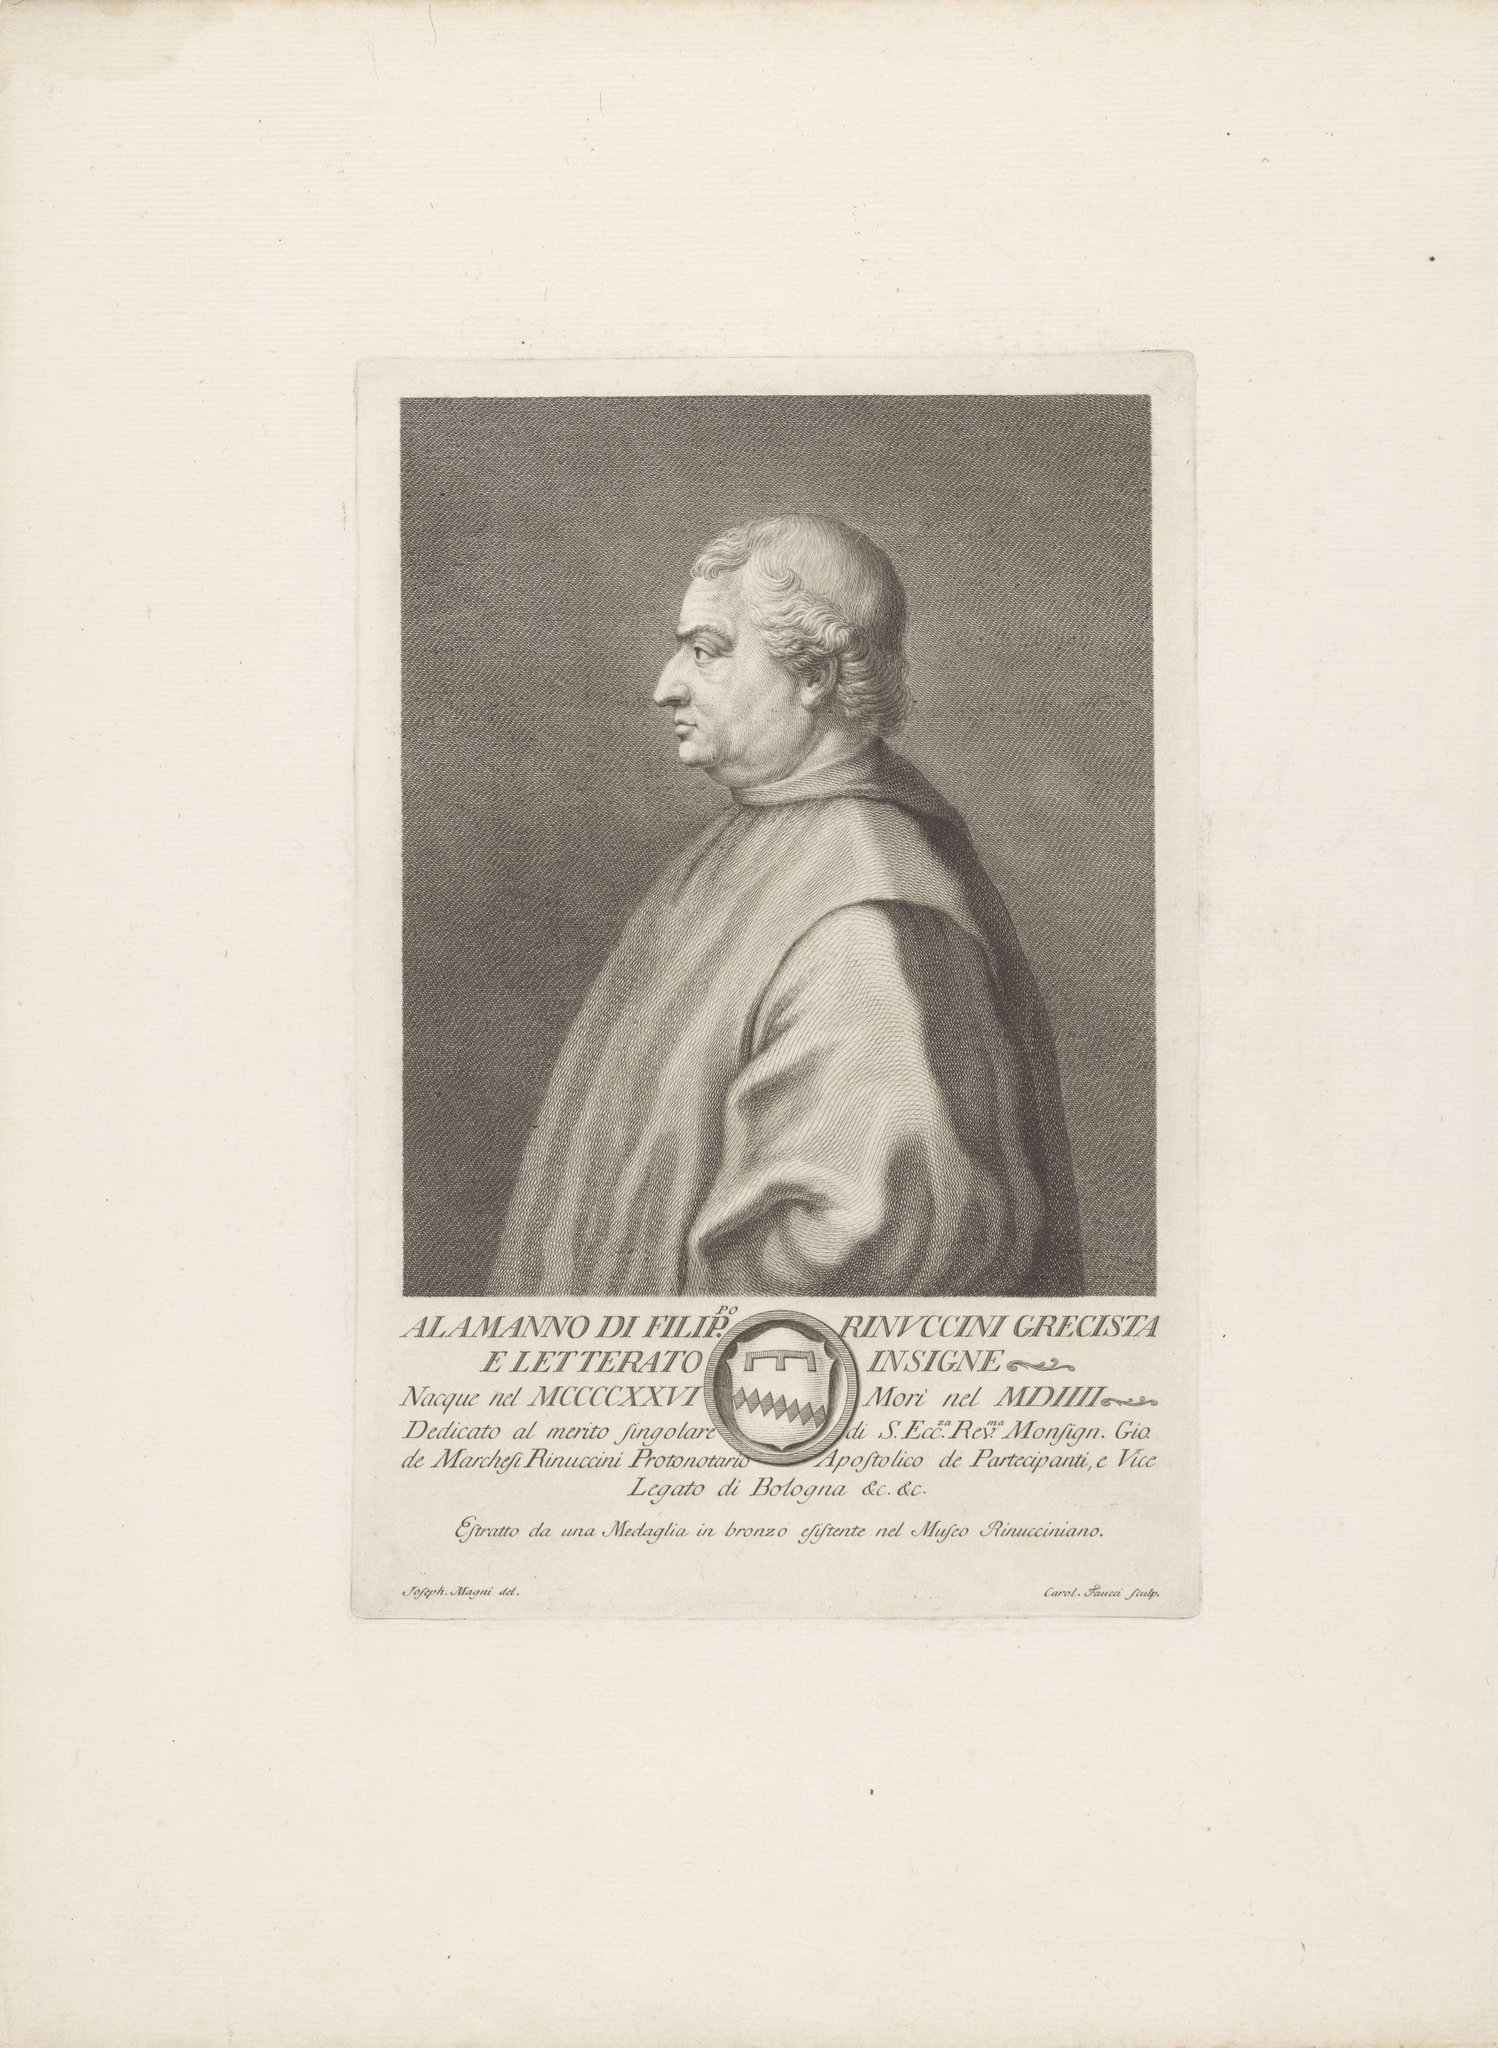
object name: print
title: Portret van letterkundige Alamanno Rinuccini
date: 1739-1784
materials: paper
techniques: etching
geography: italy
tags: historical persons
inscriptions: collector's mark: Lugt 2228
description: Deze prent maakt deel uit van een reeks portretprenten van onbekende omvang. De prenten zijn gemaakt door meedere prentmakers, onder wie Francesco Allegrini en Carlo en Raimondo Faucci. Naar een bronzen medaille.